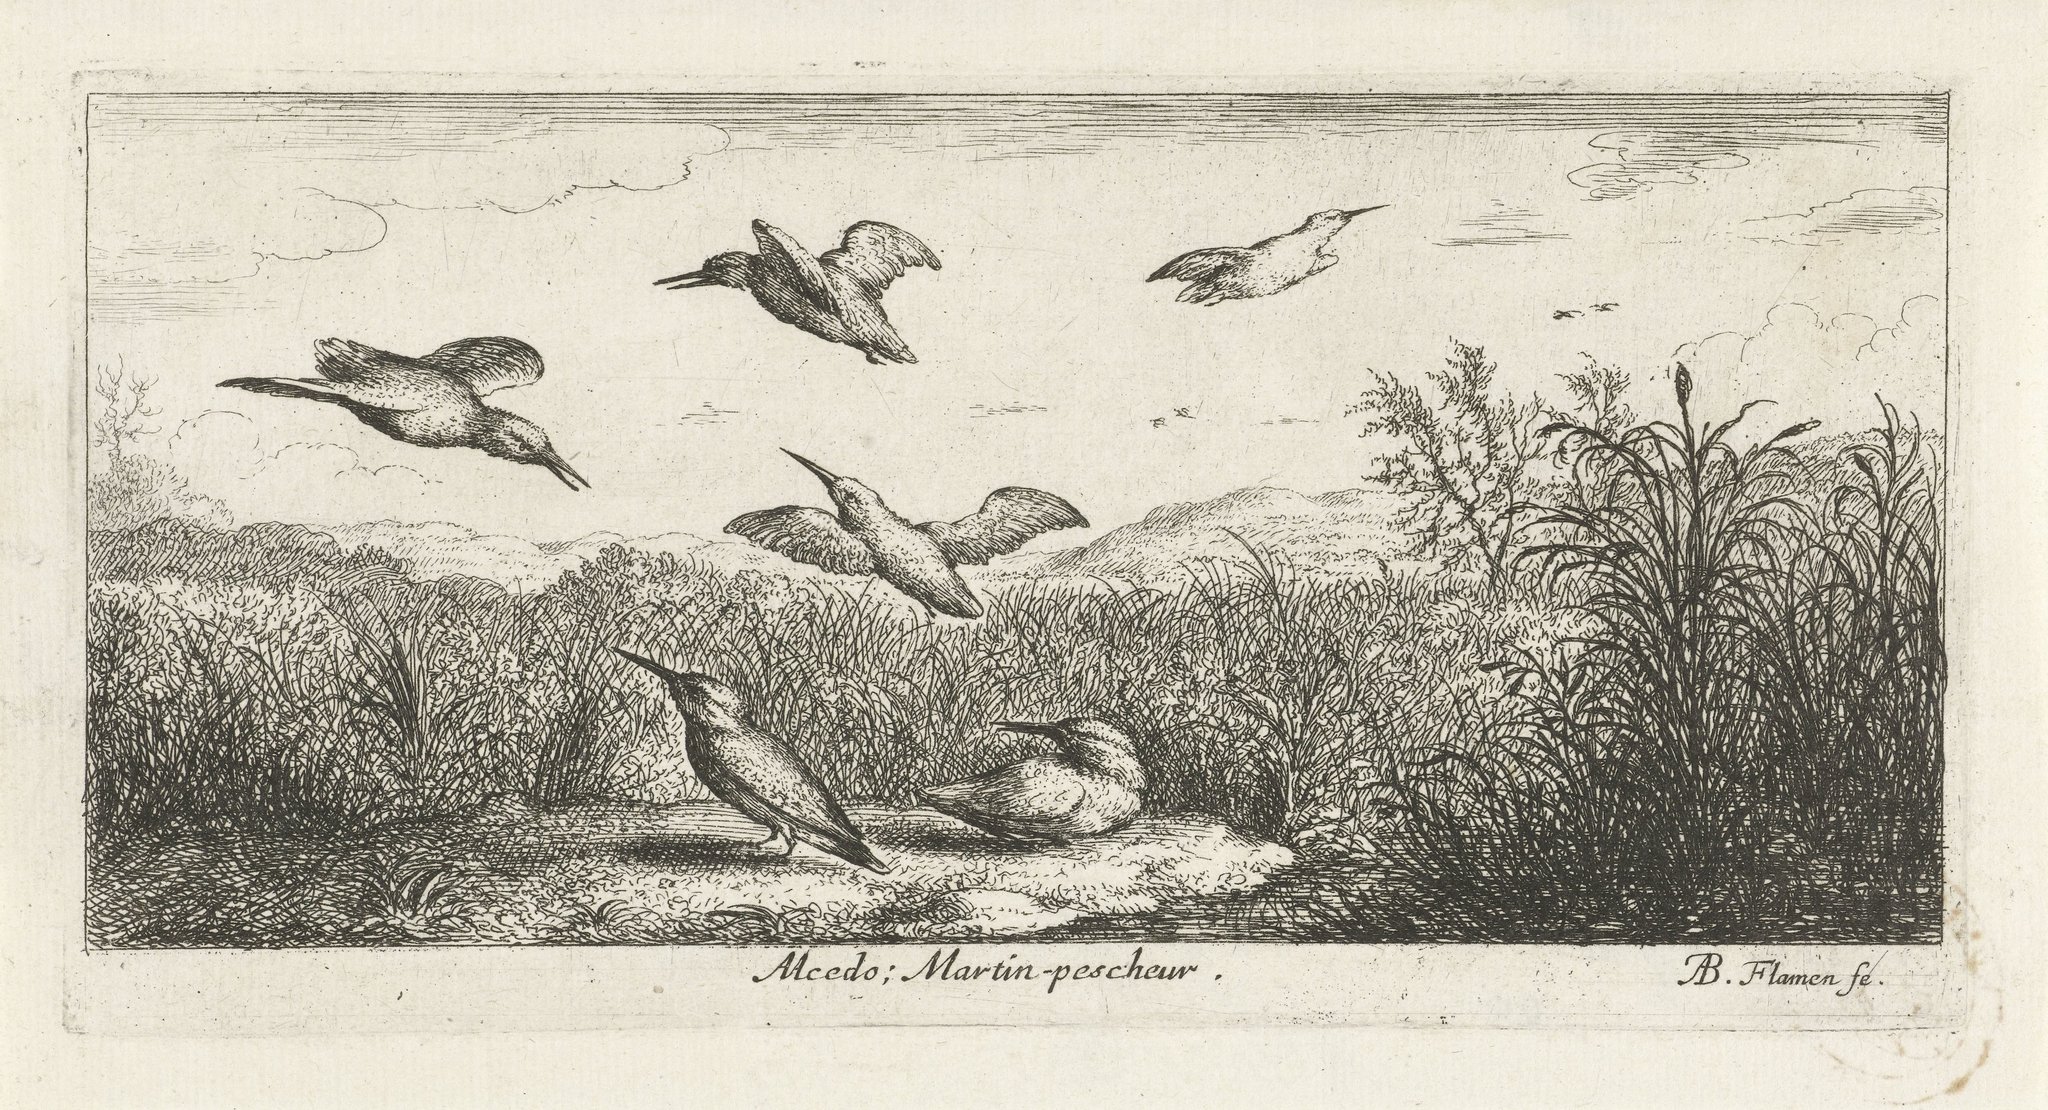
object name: print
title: Vogelboek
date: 1648-1692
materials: paper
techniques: etching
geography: france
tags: other birds: kingfisher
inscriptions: collector's mark: Lugt 240